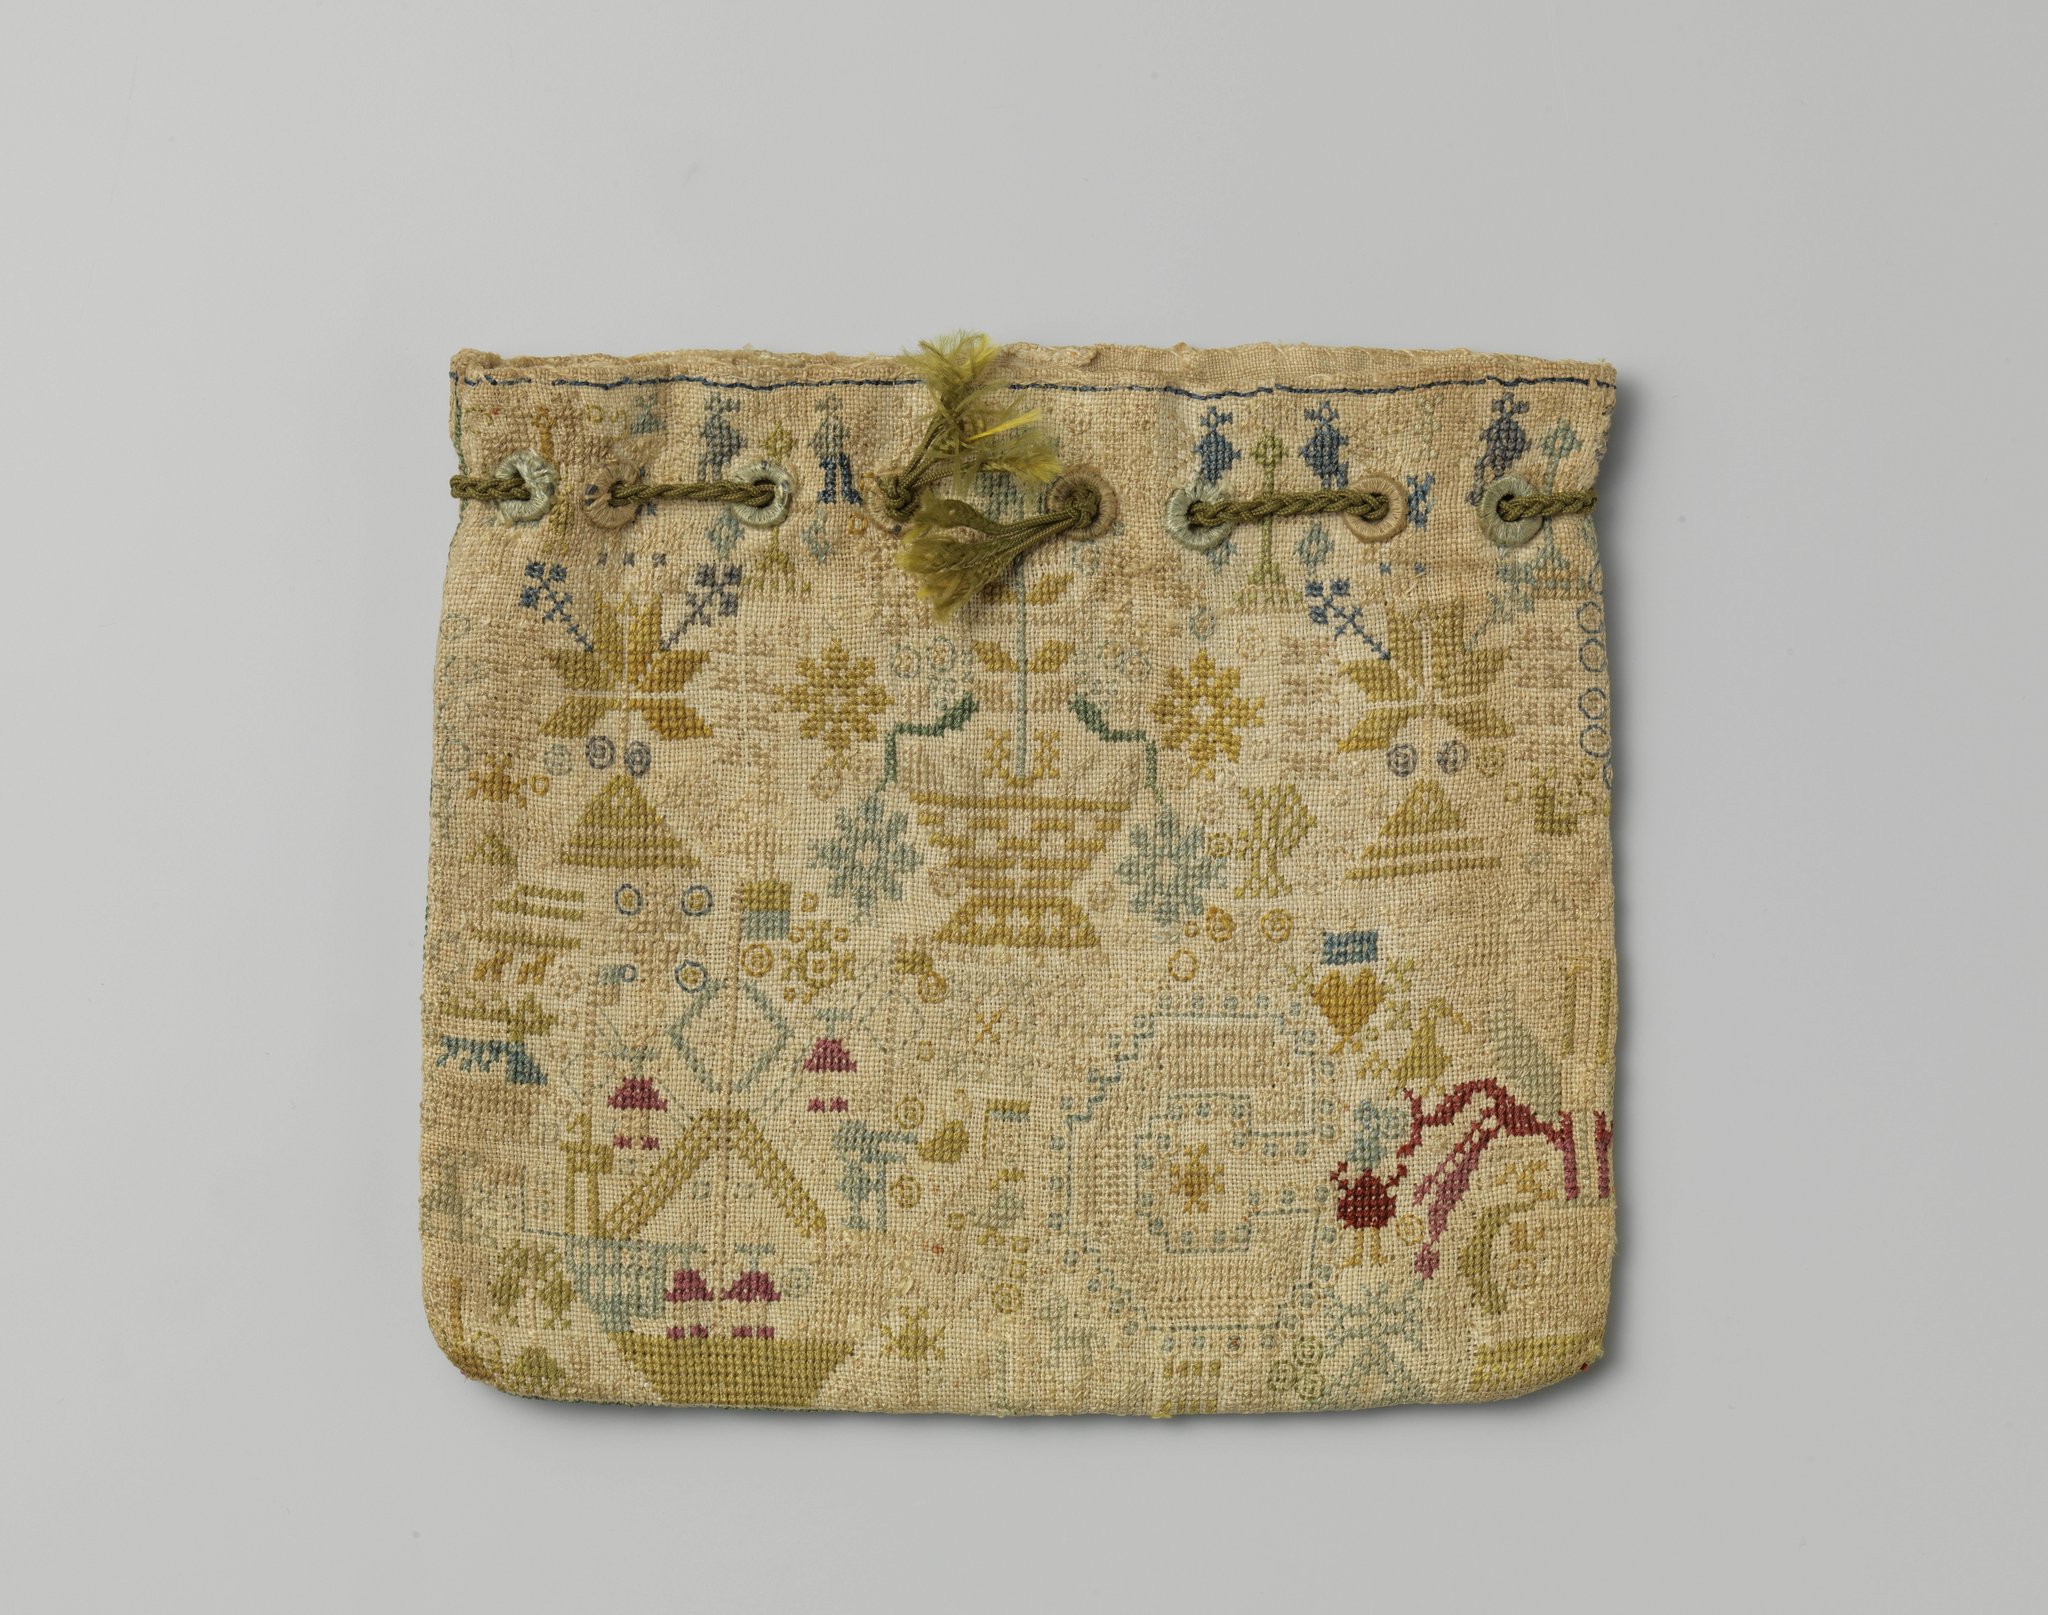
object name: merkdoek, merklap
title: Buidel of knottepong van linnen, geborduurd als merklap met kruissteken in veelkleurig zijde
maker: Anonymous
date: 1678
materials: linen, metal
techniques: cross stitching, embroidered, weave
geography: marken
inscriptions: initials: ‘CL’, date: ‘1678’, initials: ‘TP’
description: Buidel of knottepong van linnen, geborduurd als merklap met kruissteken in veelkleurig zijde. Model: vierkant, met opening aan de bovenkant. Bovenaan rand met gaatjes waardoor een nieuw(?) groen koordje. Rond de gaatjes een dun metalen oog dat met verschillende kleuren zijde in festonsteek aan het linnen is bevestigd. Gevoerd met effen linnen. Versiering: Voorkant: vaas met bloemen, waarvan aan weerskant één naar beneden hangt. Links onderaan een schip met matrozen; rechts onderaan de letter C en een figuurtje naast een halve boom waarin op een tak een vogel. De andere helft van de boom staat op de achterkant van het buideltje. Achterkant: dezelfde vaas met bloemen als aan de voorkant, ook met afhangende bloem aan weerszijden. Hiernaast aan beide zijden een rozetachtig motief, waarin acht vogels per paar zijn afgebeeld. Links onderaan de andere helft van de boom met vogels. Hiernaast de letter L en rechts hiervan en schip met matrozen. Boven de gaatjes een rij figuurtjes die twee aan twee naast de gaatjes staan.